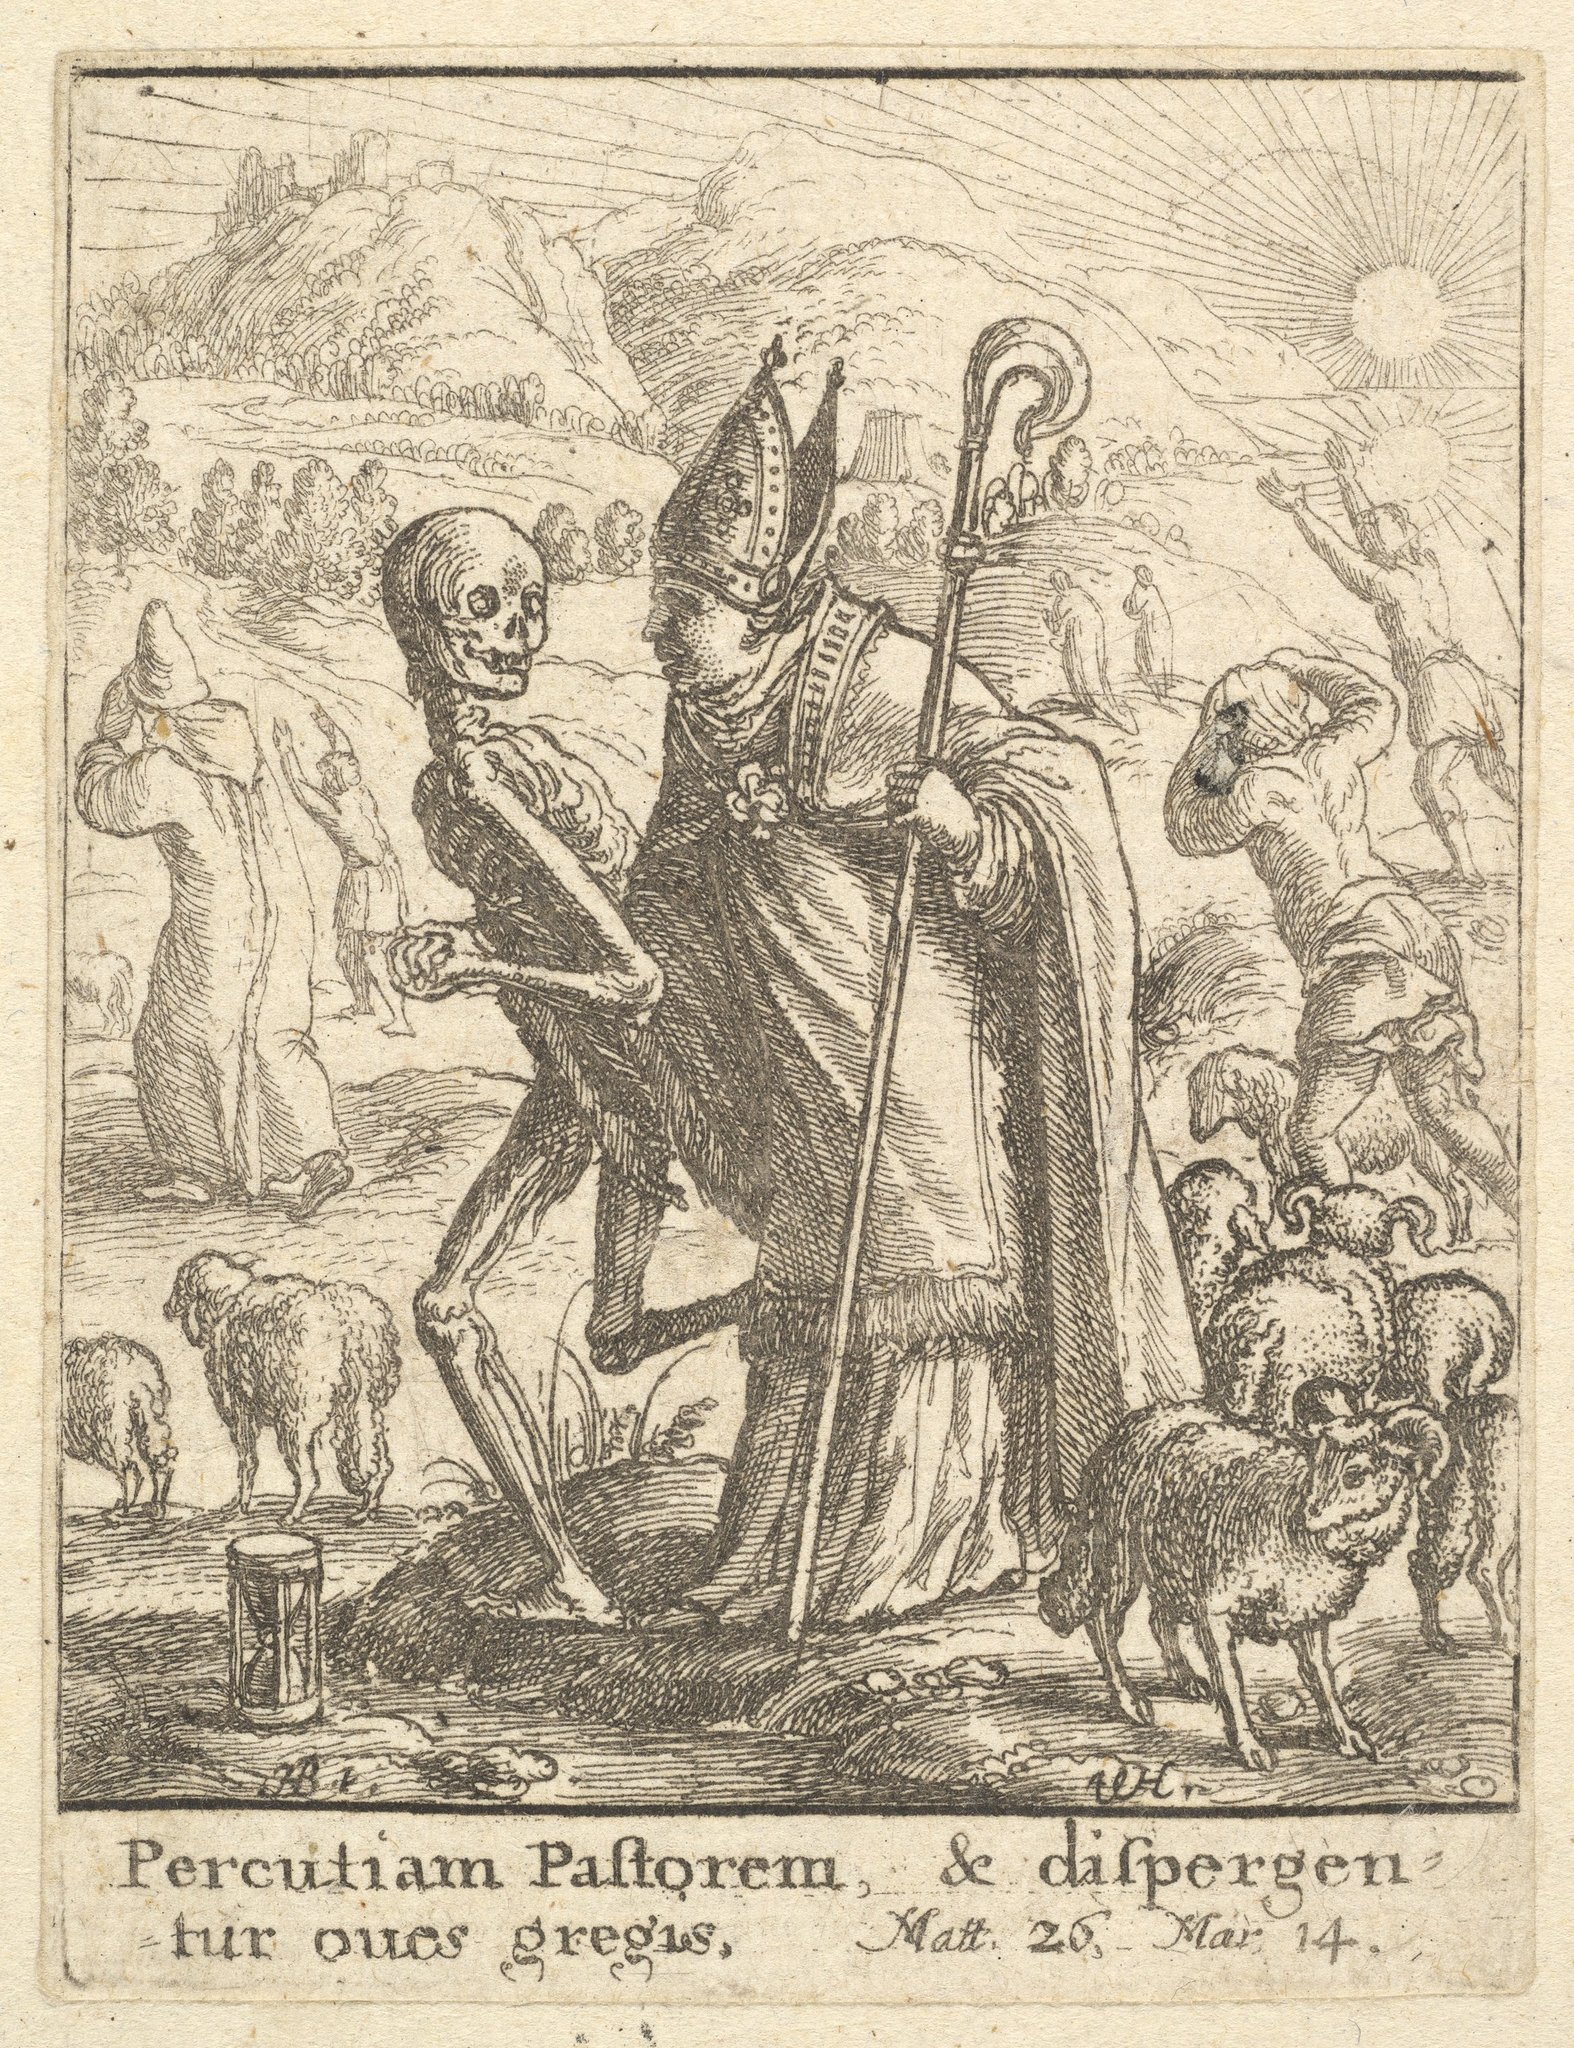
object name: print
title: Bishop, from the Dance of Death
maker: wenceslaus hollar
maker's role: artist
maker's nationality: bohemian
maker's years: 1607-1677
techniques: etching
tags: dance,skeletons,men,sheep,bishops